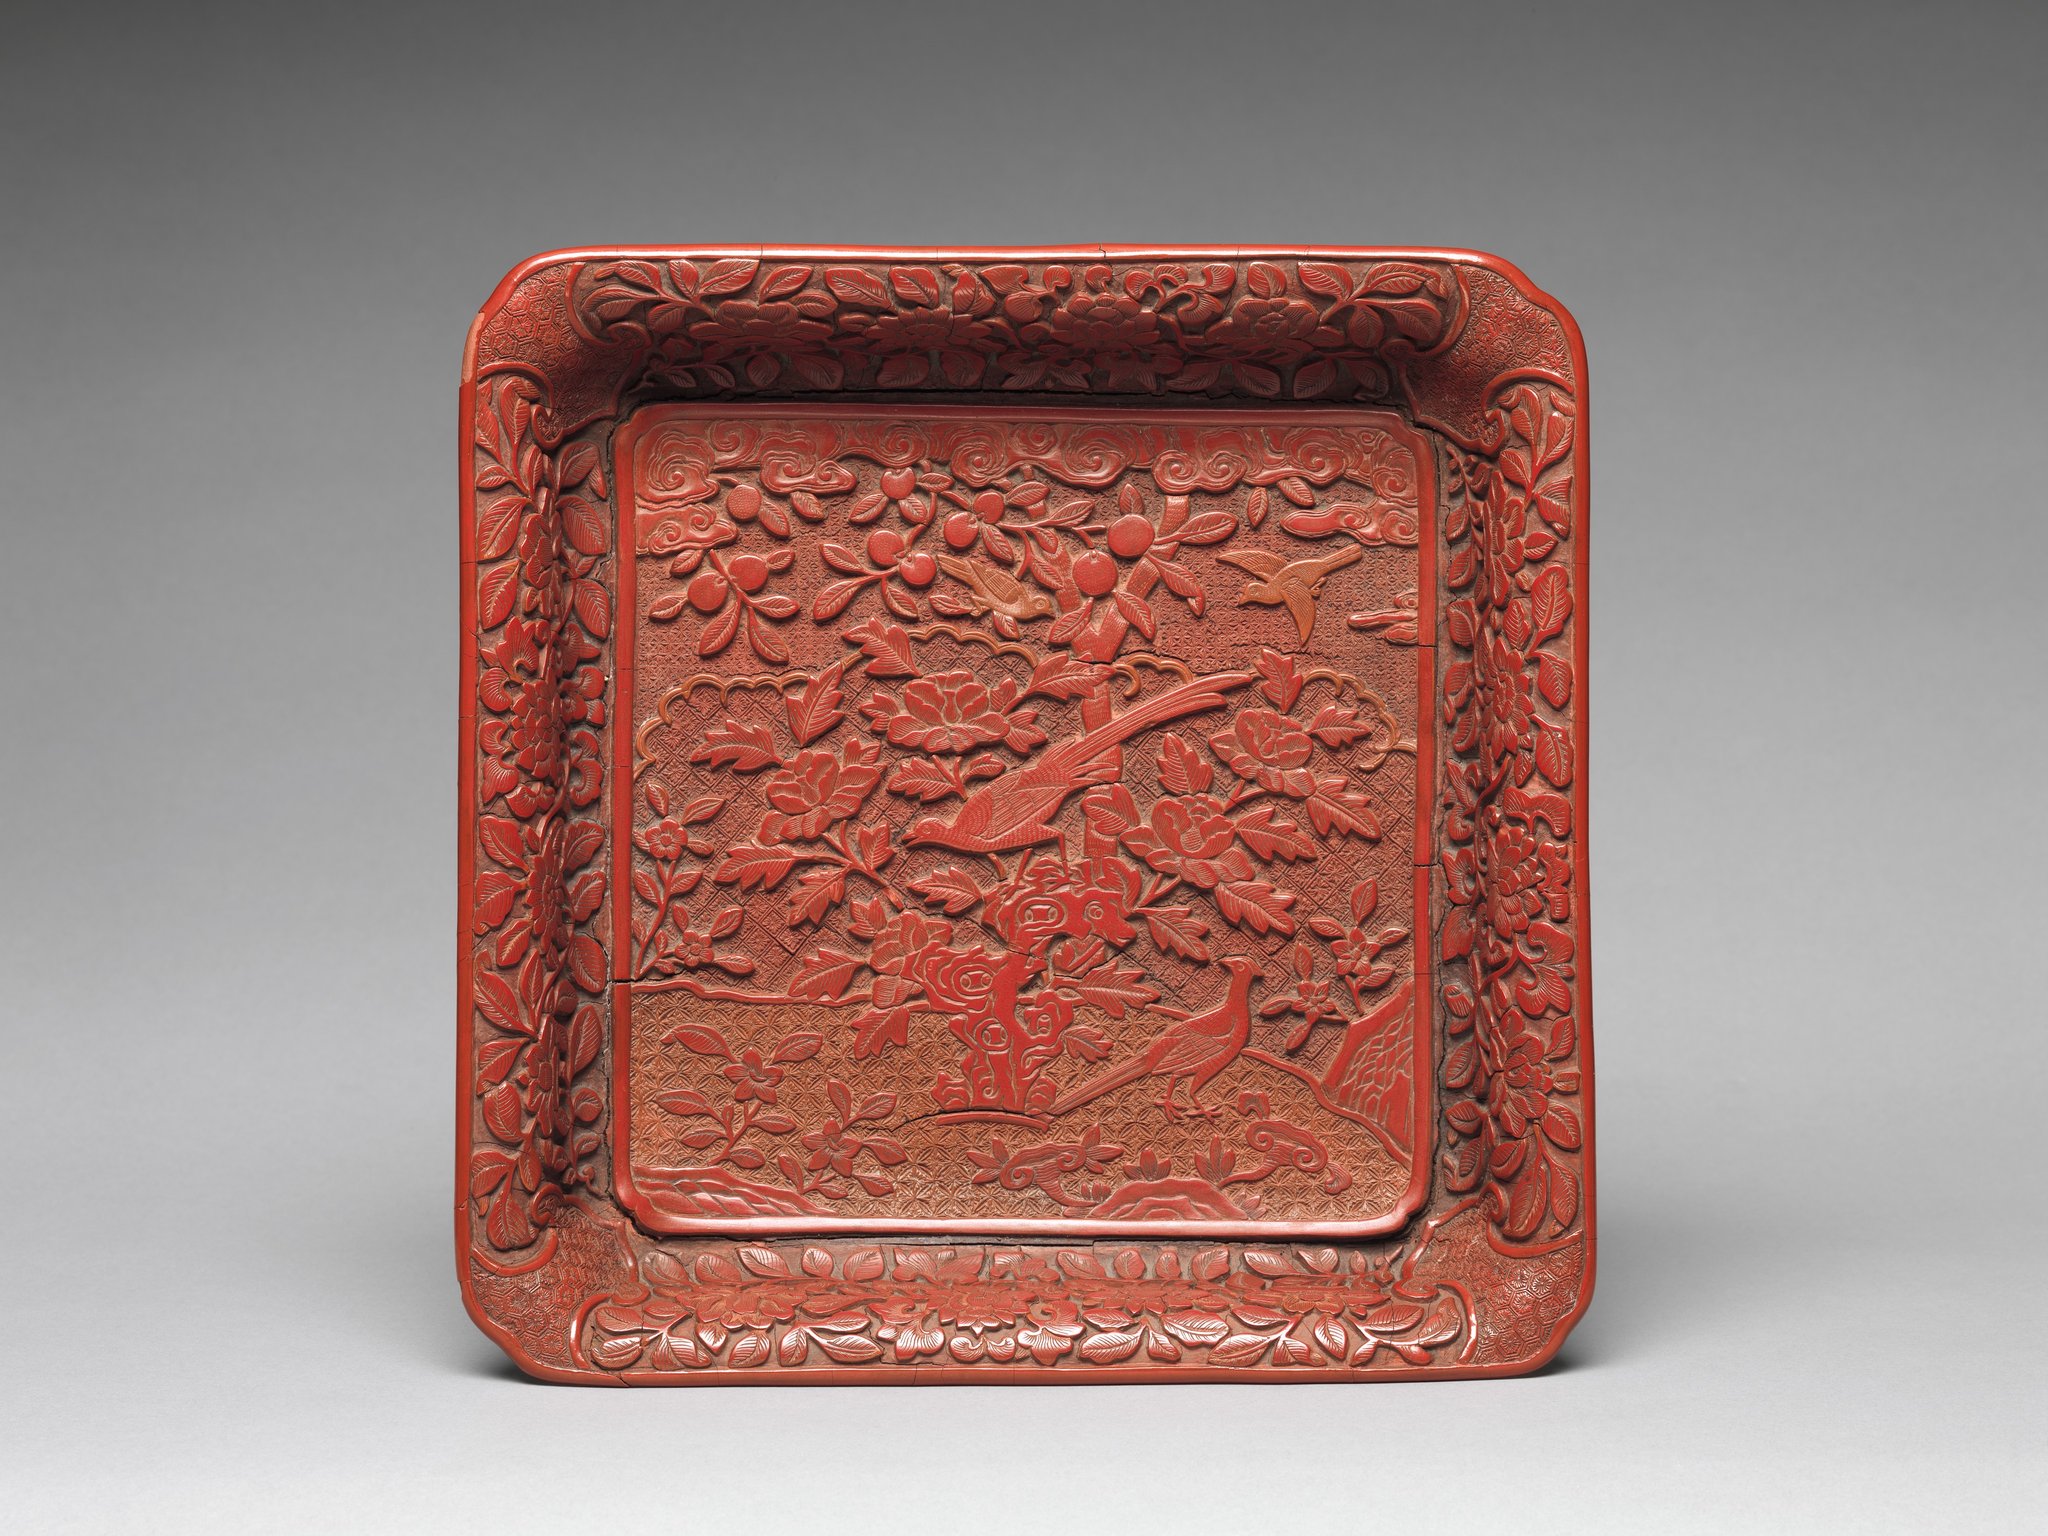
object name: tray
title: Square tray with birds in a garden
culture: chinese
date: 1501-1600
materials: lacquer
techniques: carving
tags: birds,fruit,pheasants,flowers